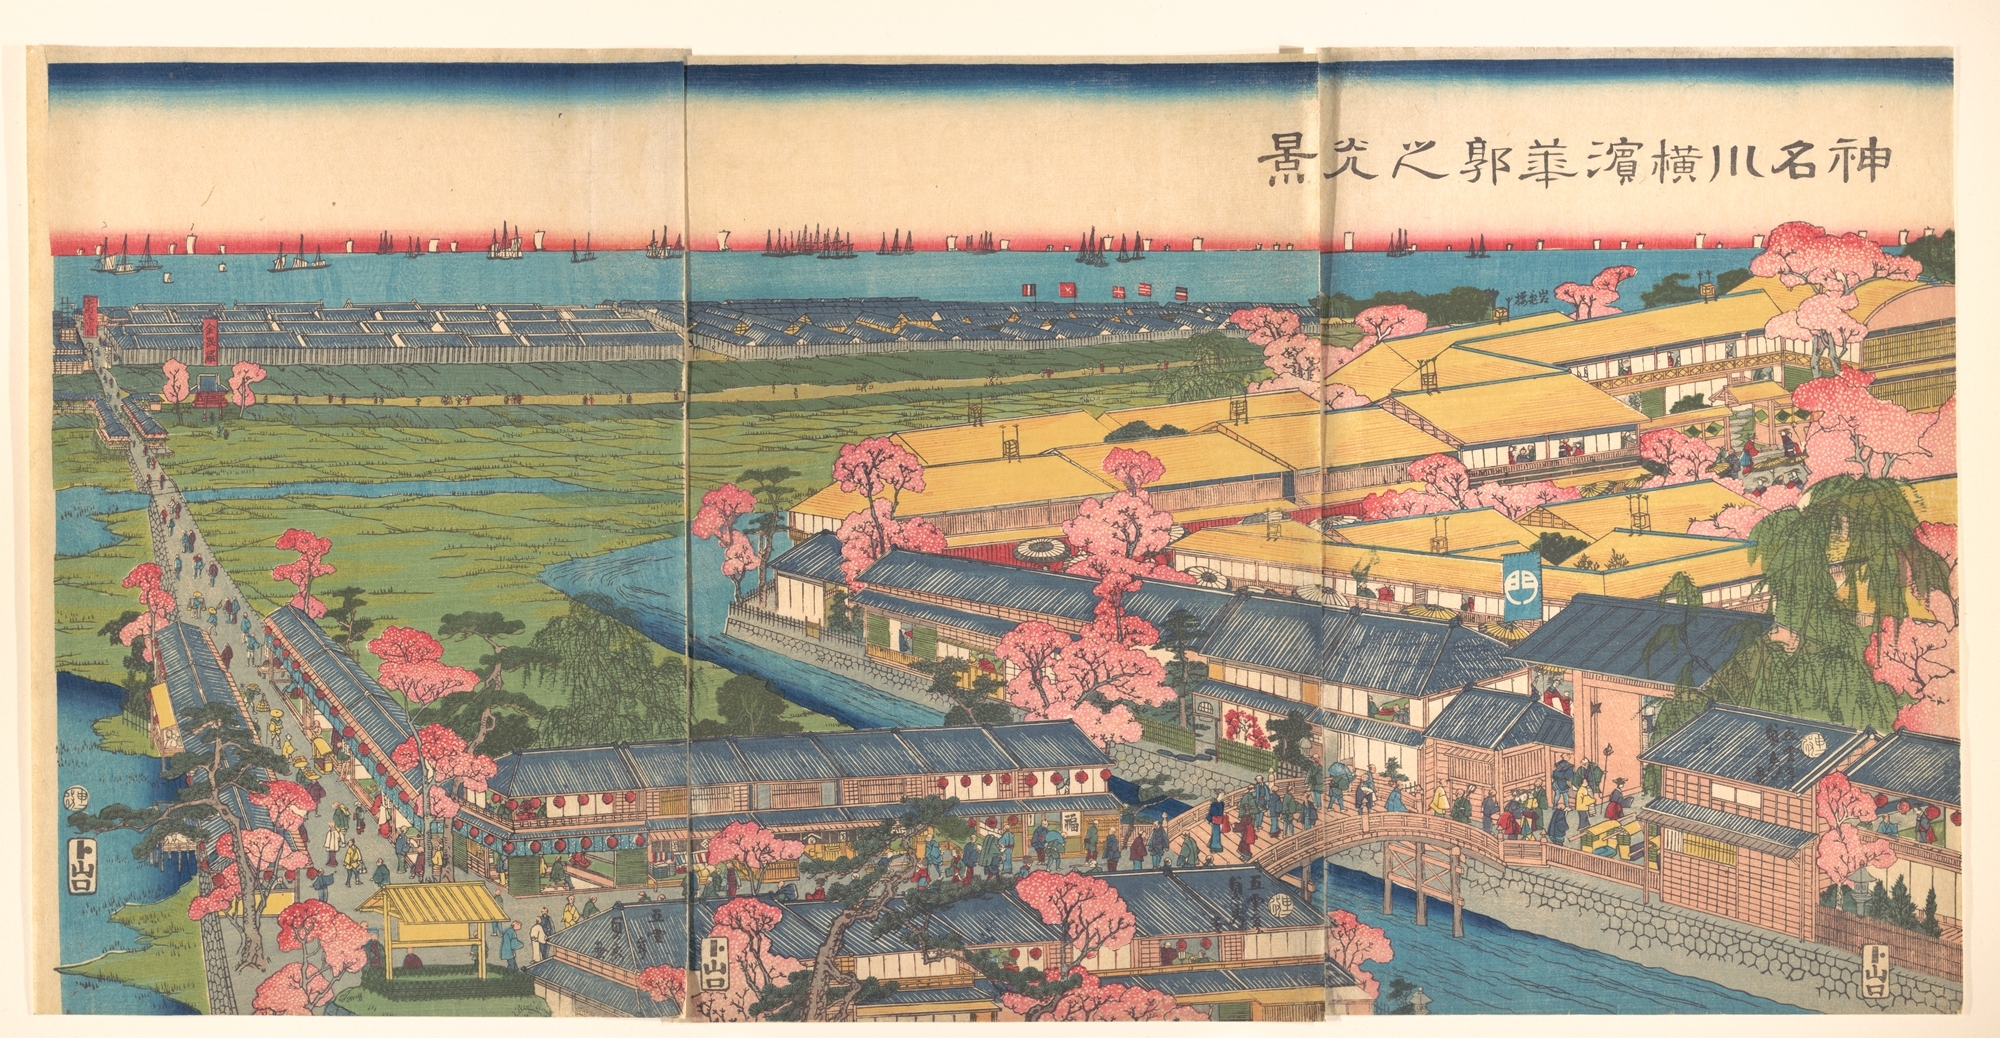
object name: print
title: View of the Yokohama Pleasure Quarters of Kanagawa at Cherry Blossom Time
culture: japanese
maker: utagawa (gountei) sadahide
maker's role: artist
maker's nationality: japanese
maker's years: 1807-1873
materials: ink, paper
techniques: woodblock print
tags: houses,bridges,trees